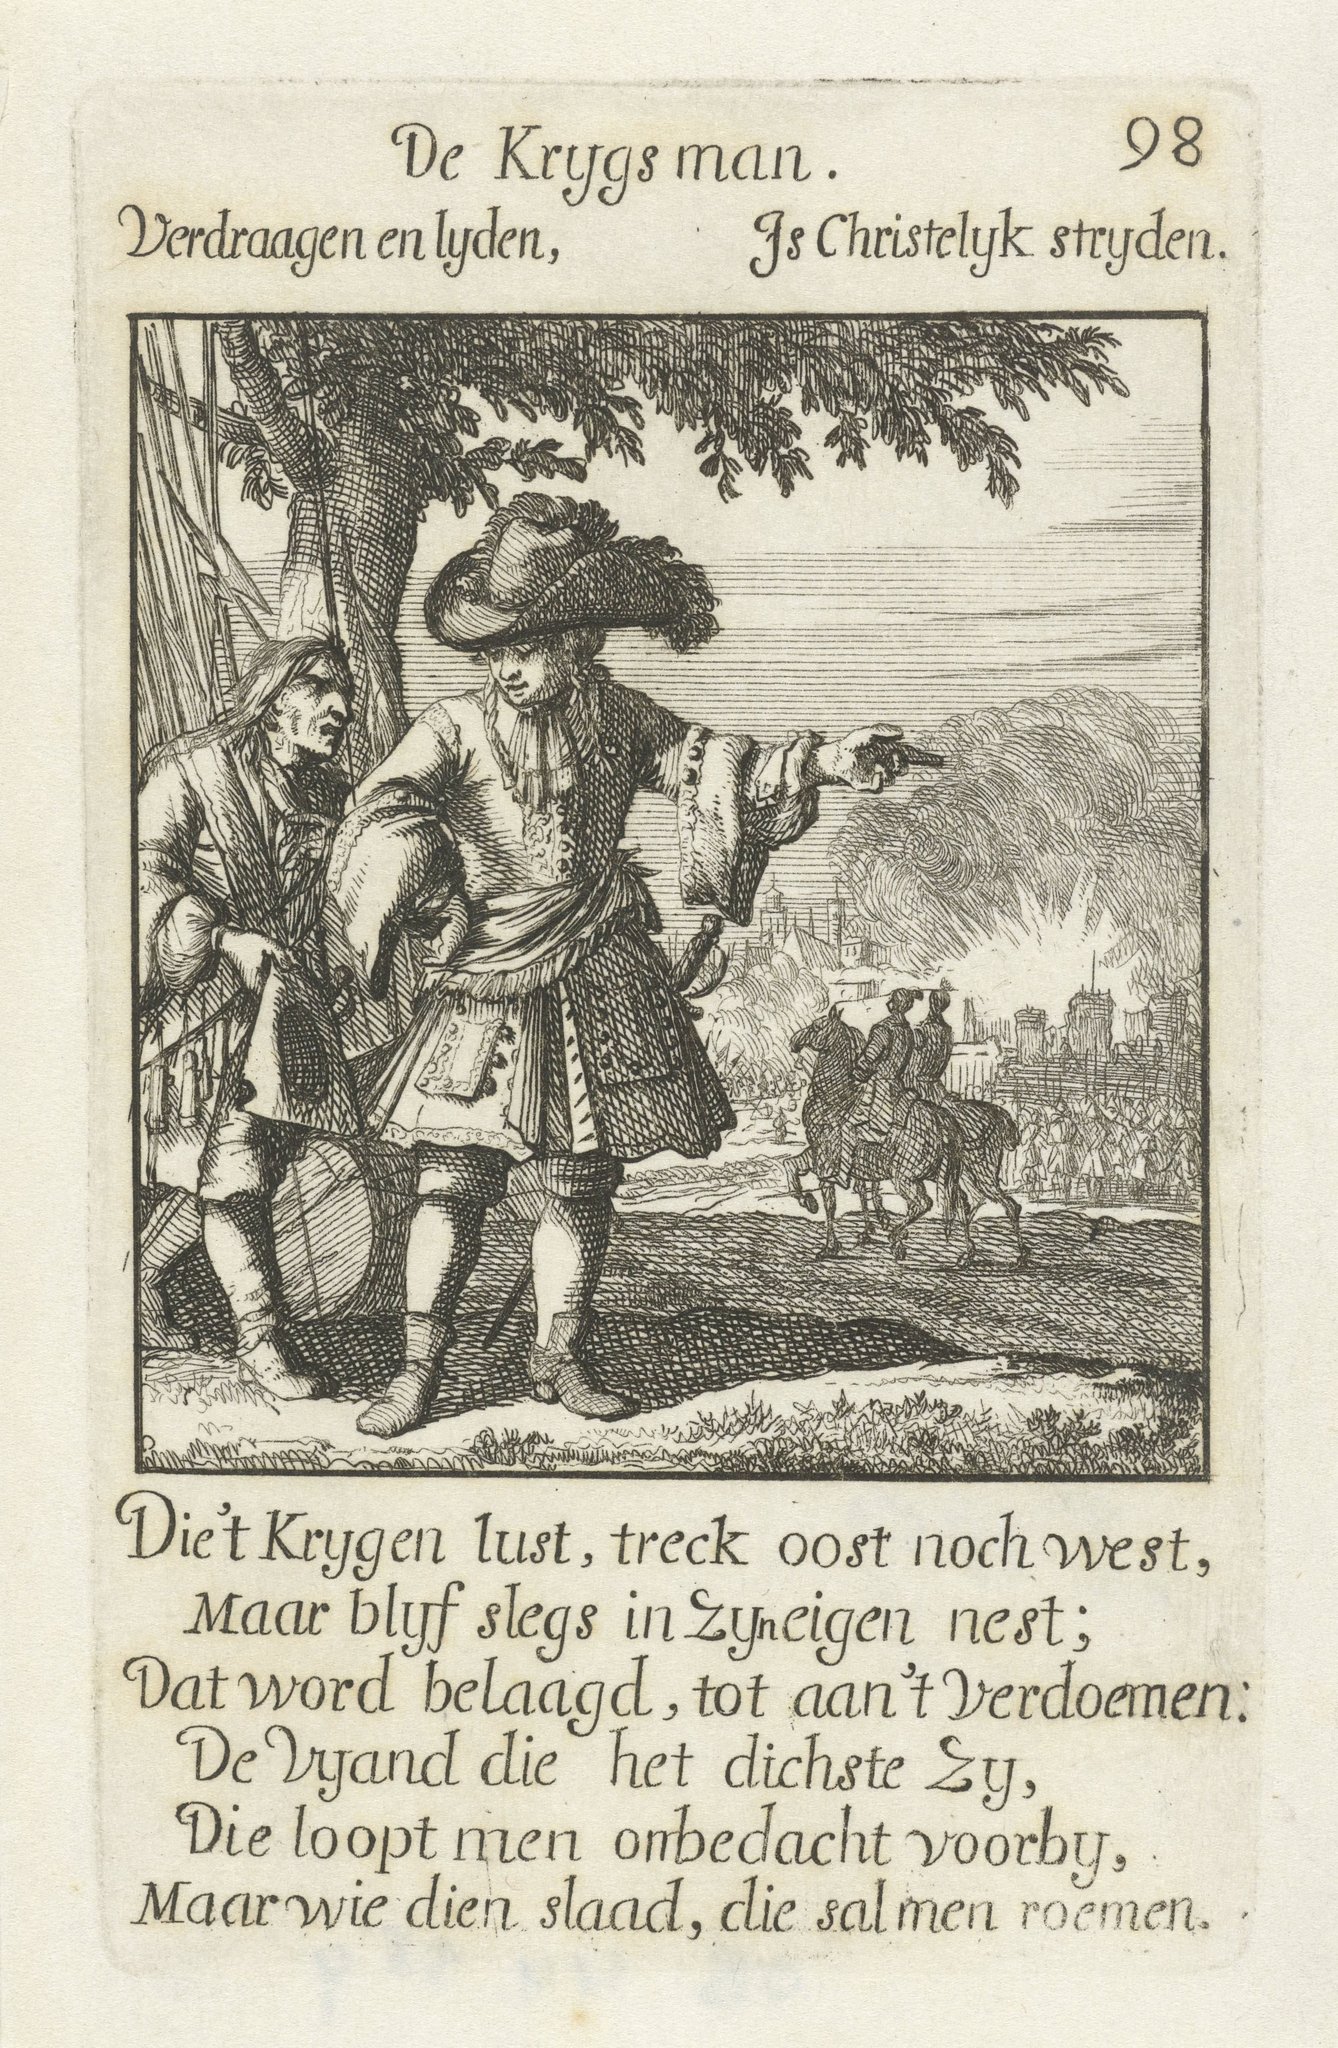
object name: print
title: De Krygsman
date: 1694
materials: paper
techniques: etching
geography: amsterdam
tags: officer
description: Maakt deel uit van de 100-delige serie beroepsprenten van Jan en Caspar Luyken, getiteld: Het menselyk bedryf. S.l.s.n., 1694 (eerste druk).